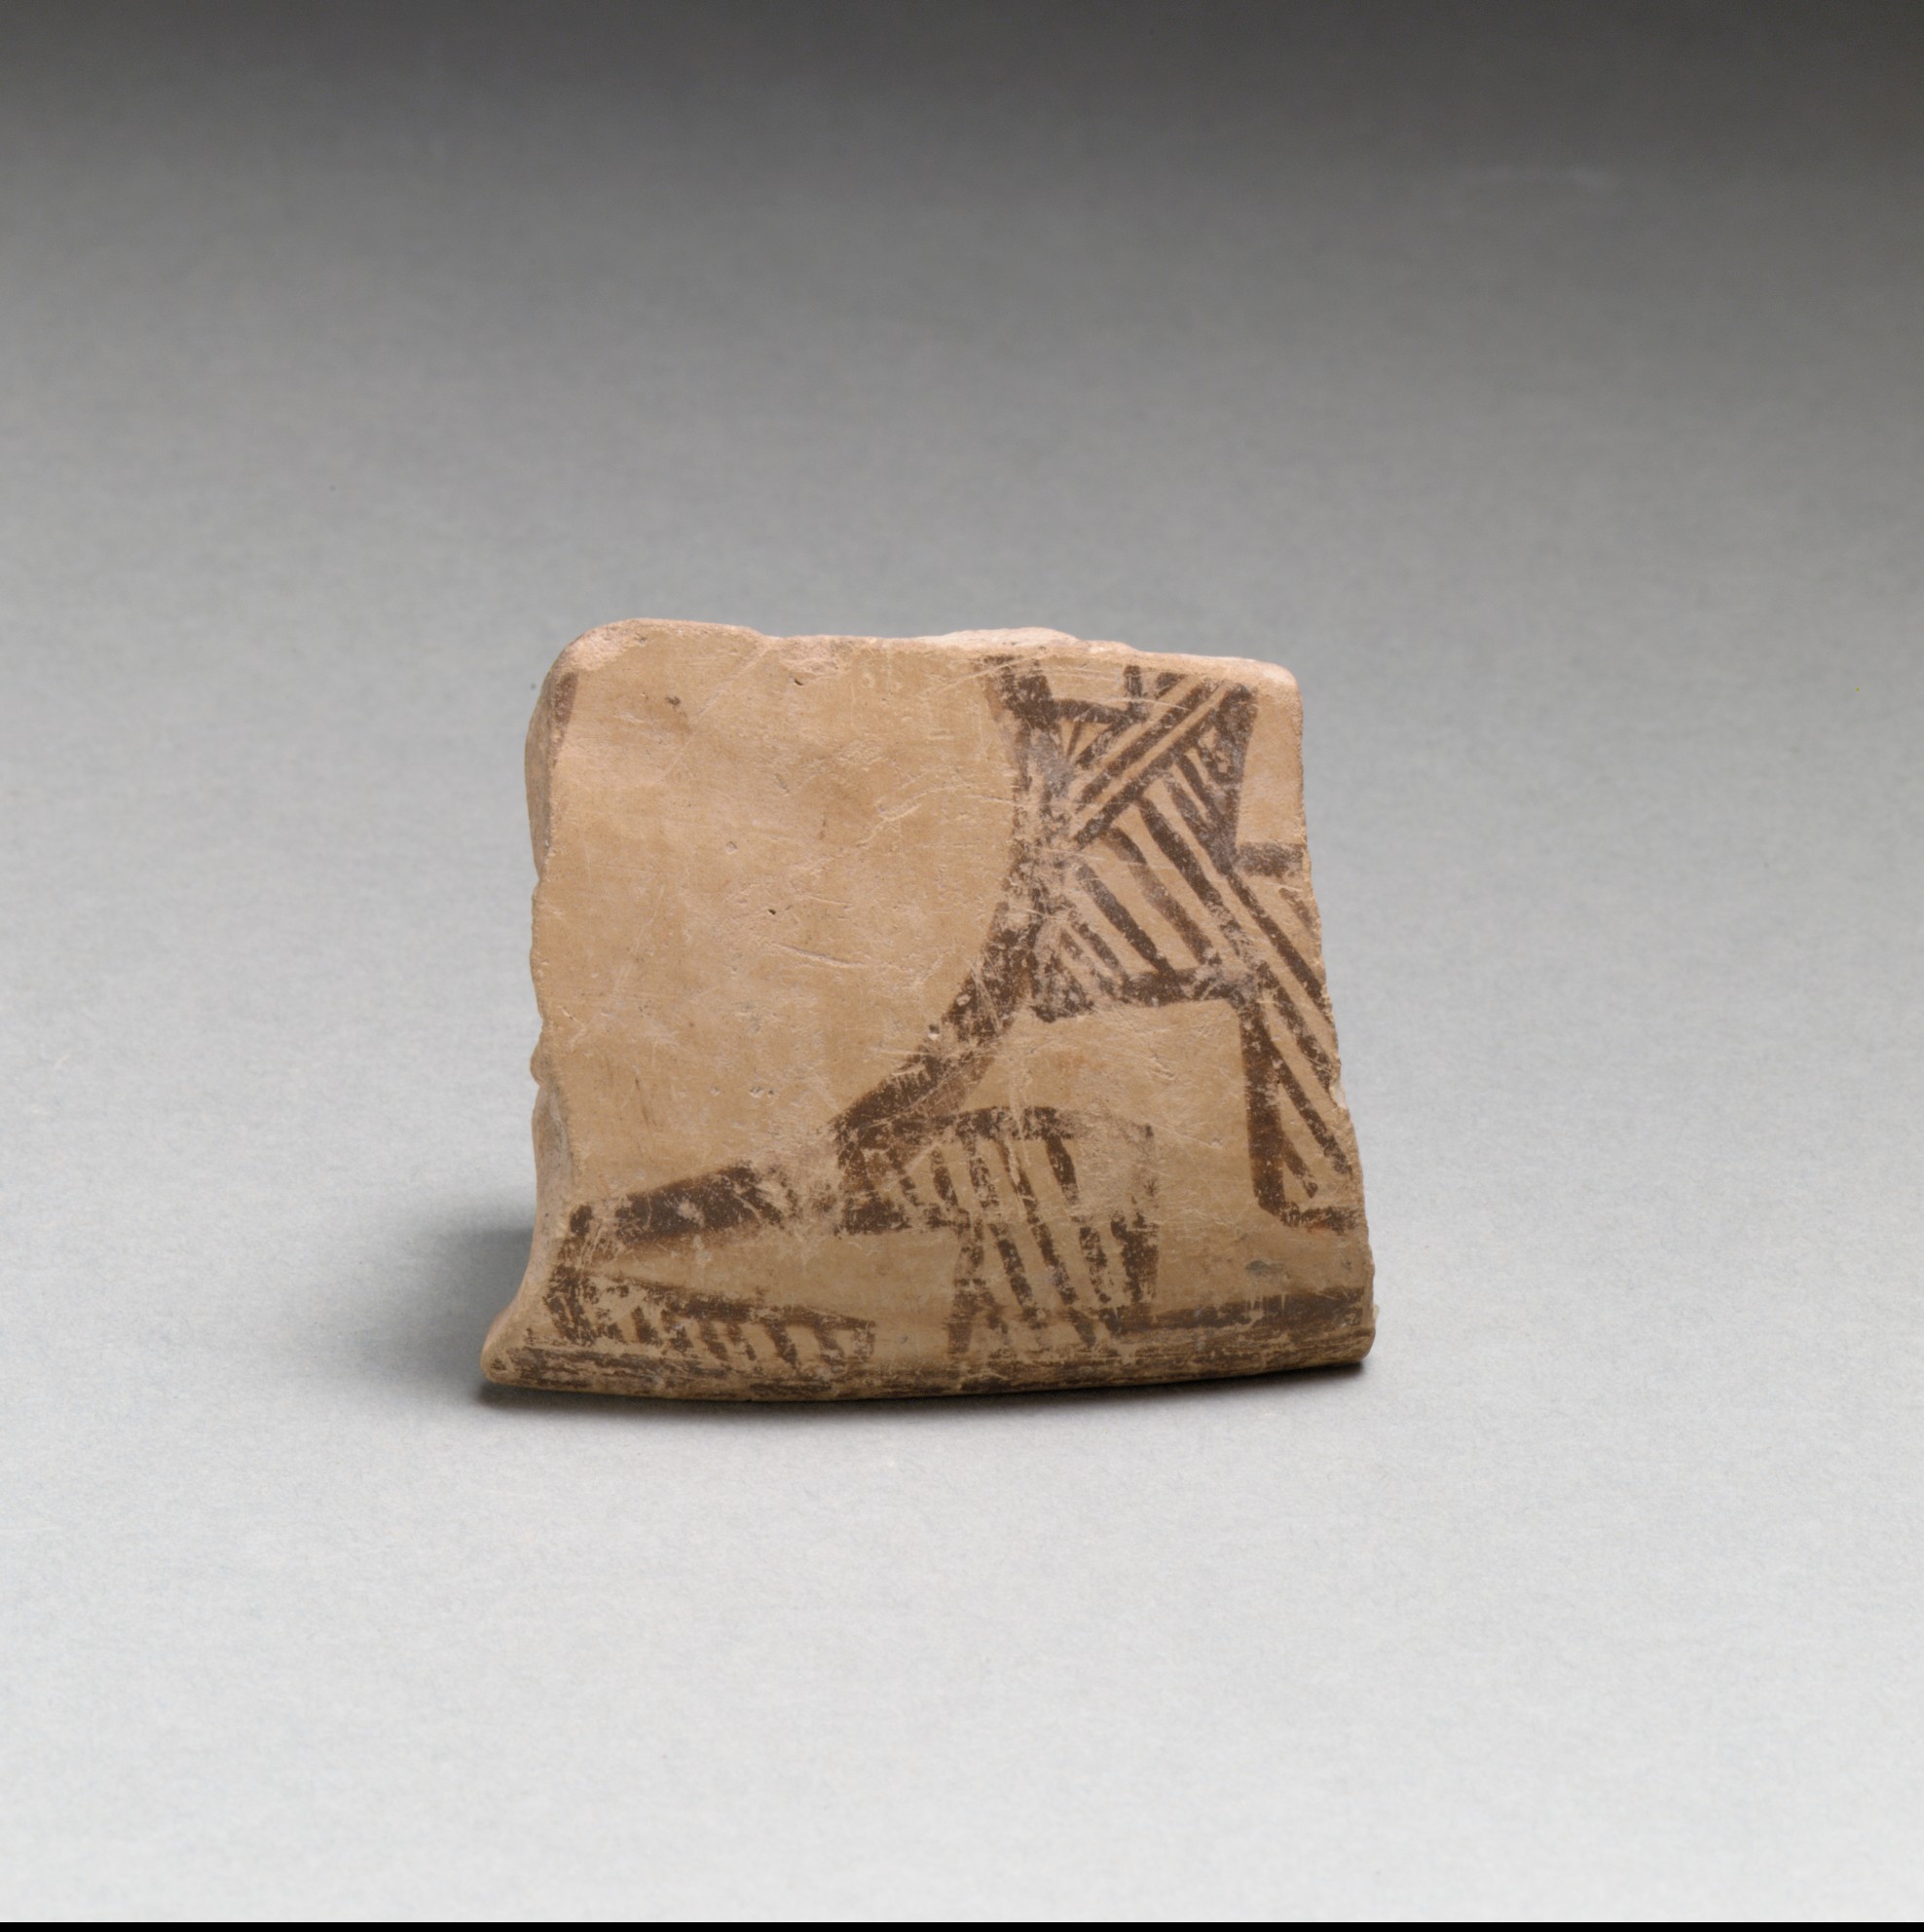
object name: vase fragment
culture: neolithic, thessaly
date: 4000-3000 BCE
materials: terracotta